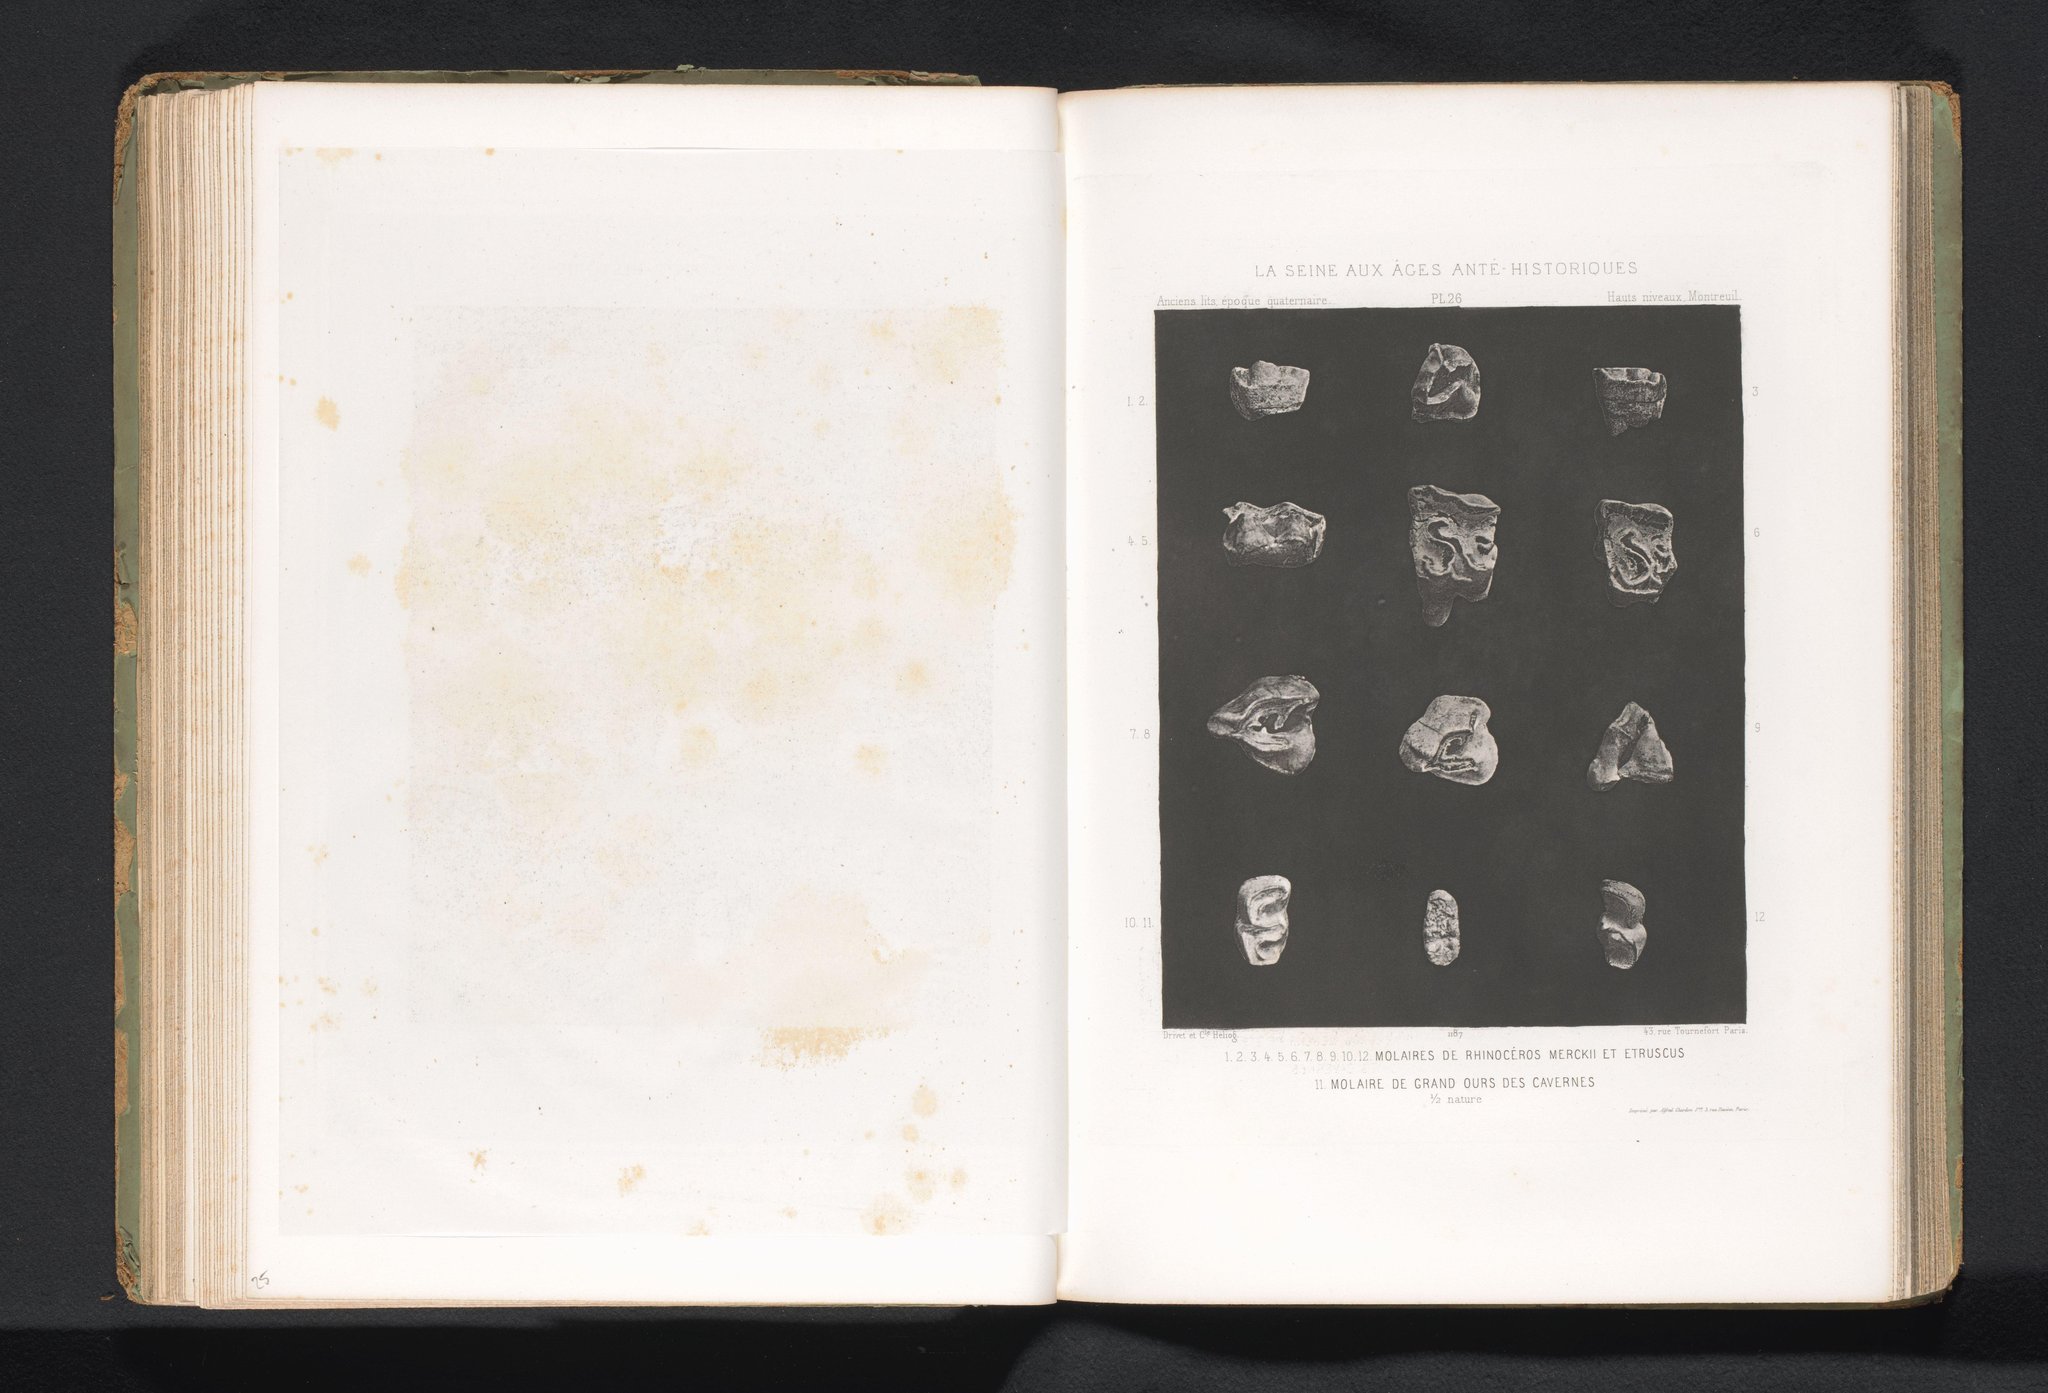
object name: page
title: Twaalf kiezen van een neushoorn en een holenbeer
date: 1864-1869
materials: paper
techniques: photoaquatint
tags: mammals (+ skeleton of an animal), palaeontology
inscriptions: inscription: ‘1/2 nature’, inscription: ‘1. 2. 3. 4. 5. 6. 7. 8. 9. 10. 12 MOLAIRES DE RHINOCÉROS MERCKII ET ETRUSCUS 11. MOLAIRE DE GRAND OURS DES CAVERNES’, inscription: ‘PL. 26’, inscription: ‘1187’